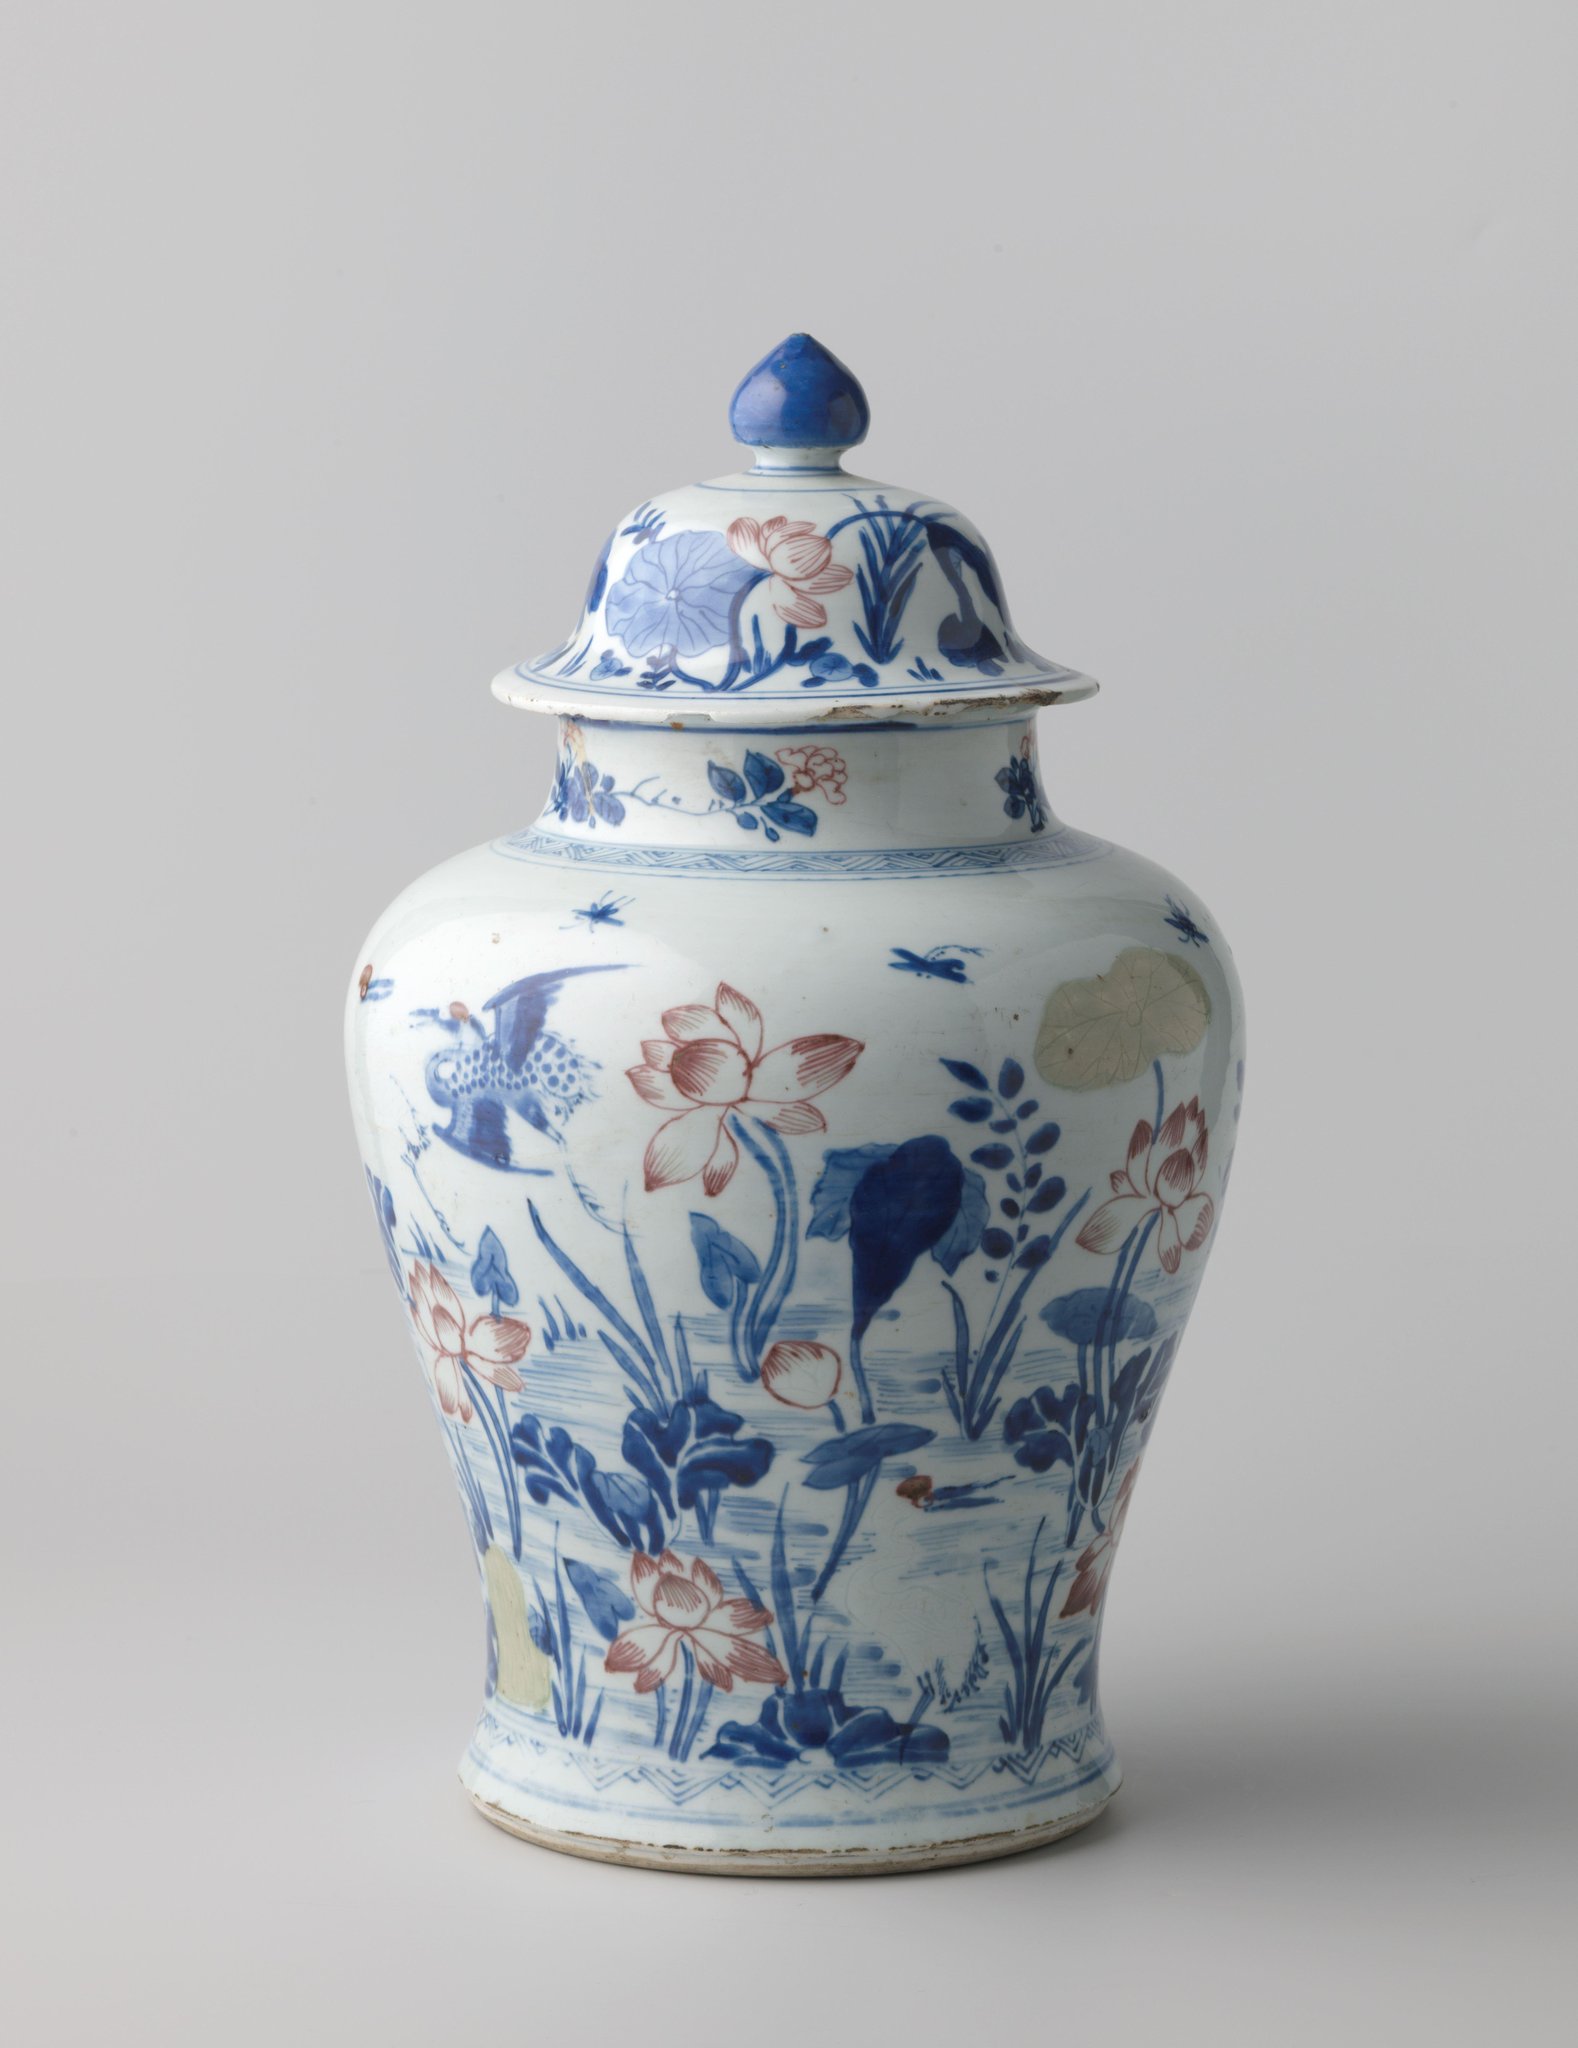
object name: lid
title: Baluster covered jar with lotus plants and cranes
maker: Anonymous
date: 1700-1724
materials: cobalt, copper, glaze, paint, porcelain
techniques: firing, turning, vitrification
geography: china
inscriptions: mark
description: Deksel van balustervormige dekselpot van porselein met een spreidende voet en een brede hals. Beschilderd in onderglazuur blauw en rood en een wit slib. Op de deksel lotusplanten. Twee scherven uit de deksel. Onderglazuur blauw met koperrood.